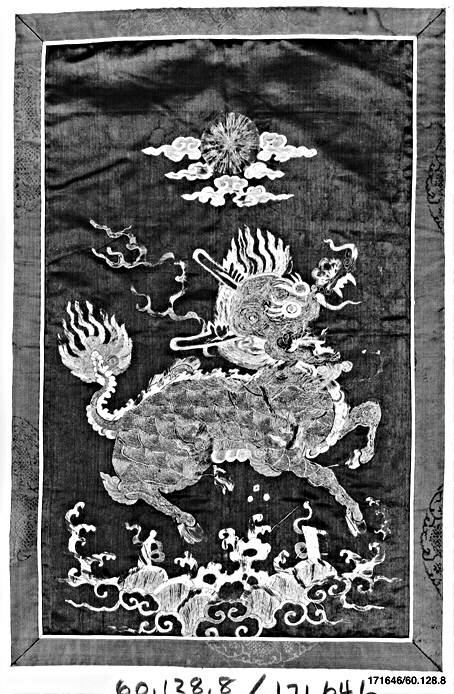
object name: vertical panel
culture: chinese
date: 1601-1700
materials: cotton, metal thread, silk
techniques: bookbinding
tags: mythical creatures